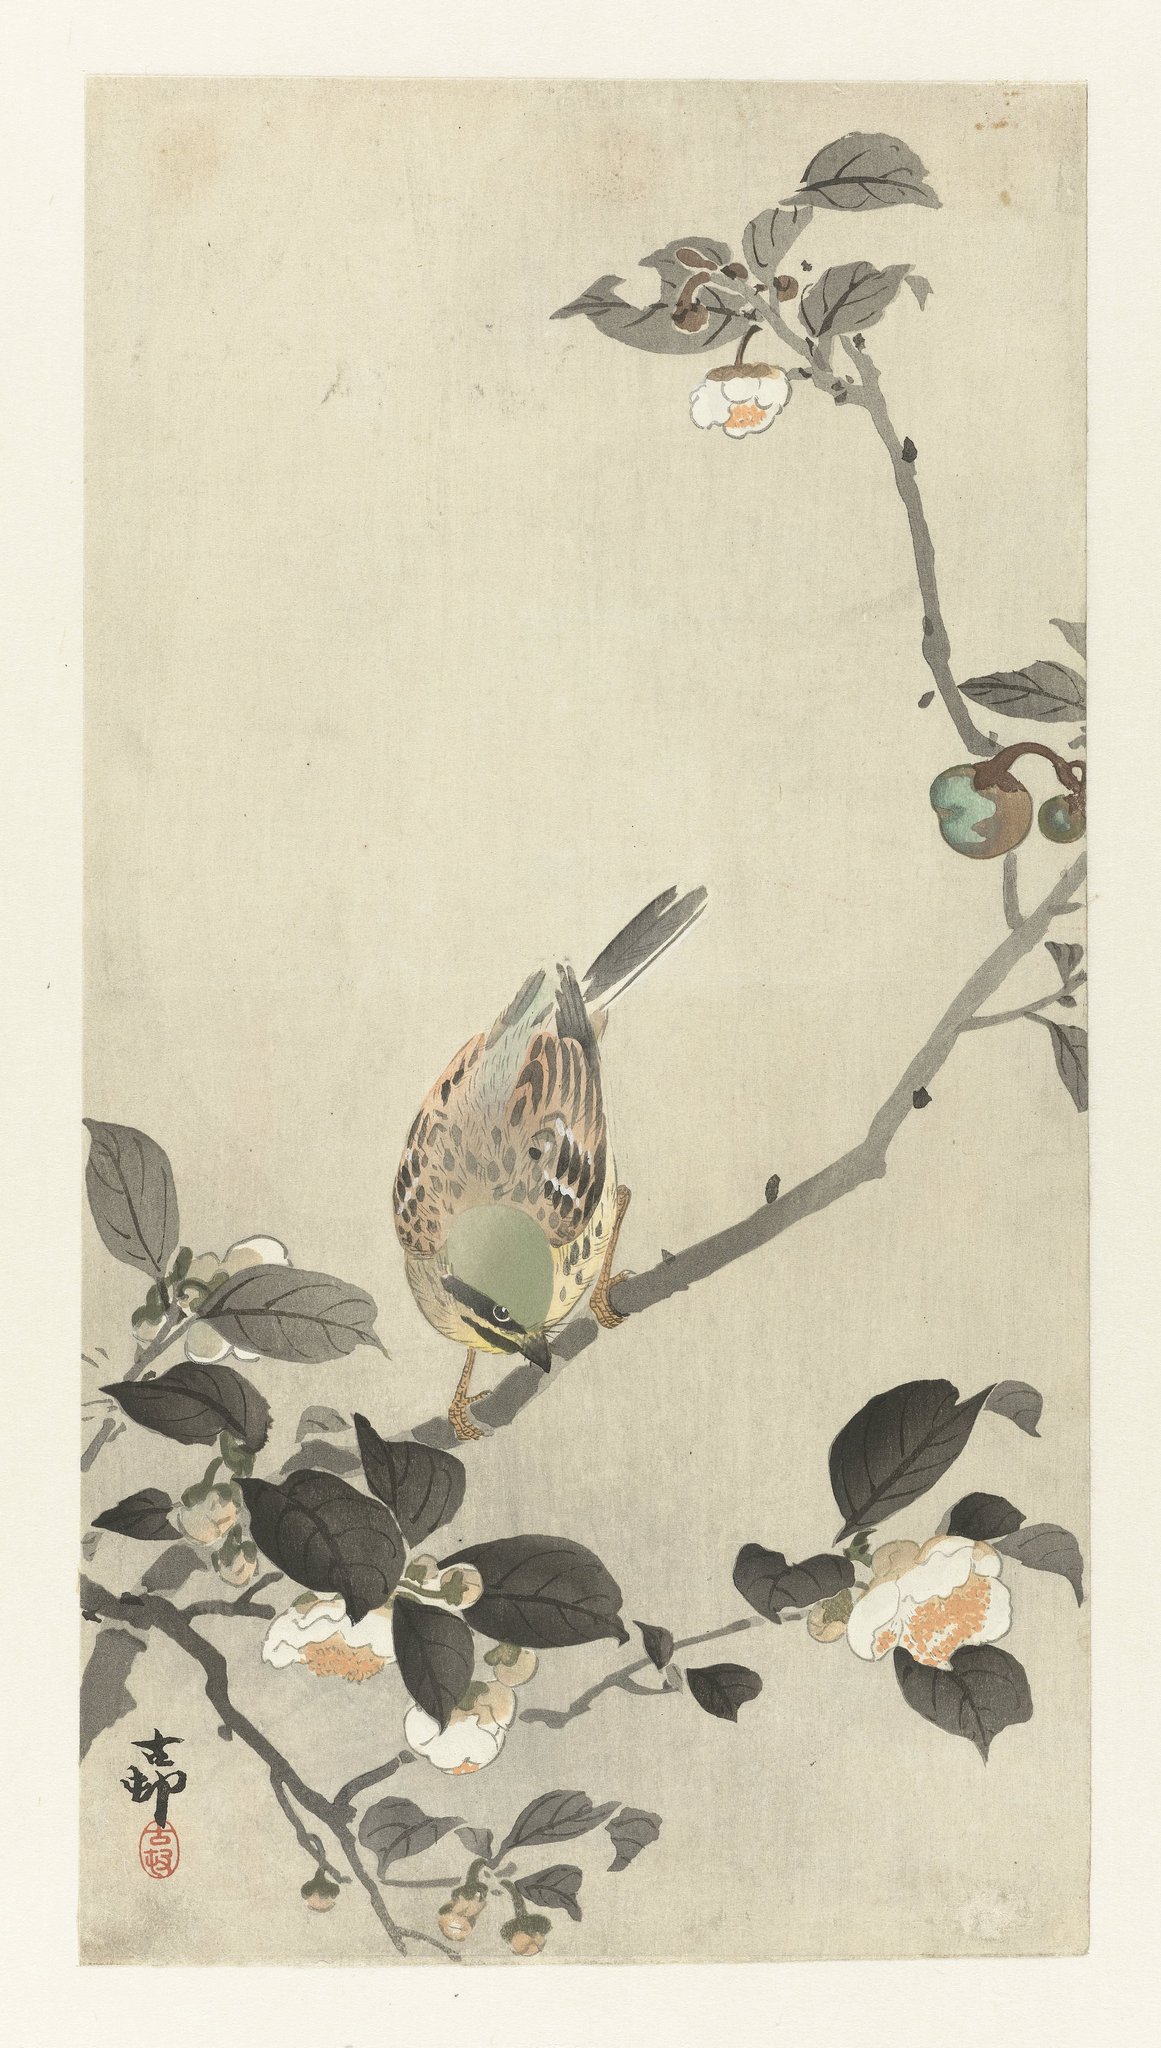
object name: print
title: Gors op bloesemtak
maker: ohara koson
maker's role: print maker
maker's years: 1877-1945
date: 1900-1930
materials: paper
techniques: woodcut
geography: tokyo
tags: birds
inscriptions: collector's mark: Lugt 2228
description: Vogel met groene kop, op tak met witte bloemen.